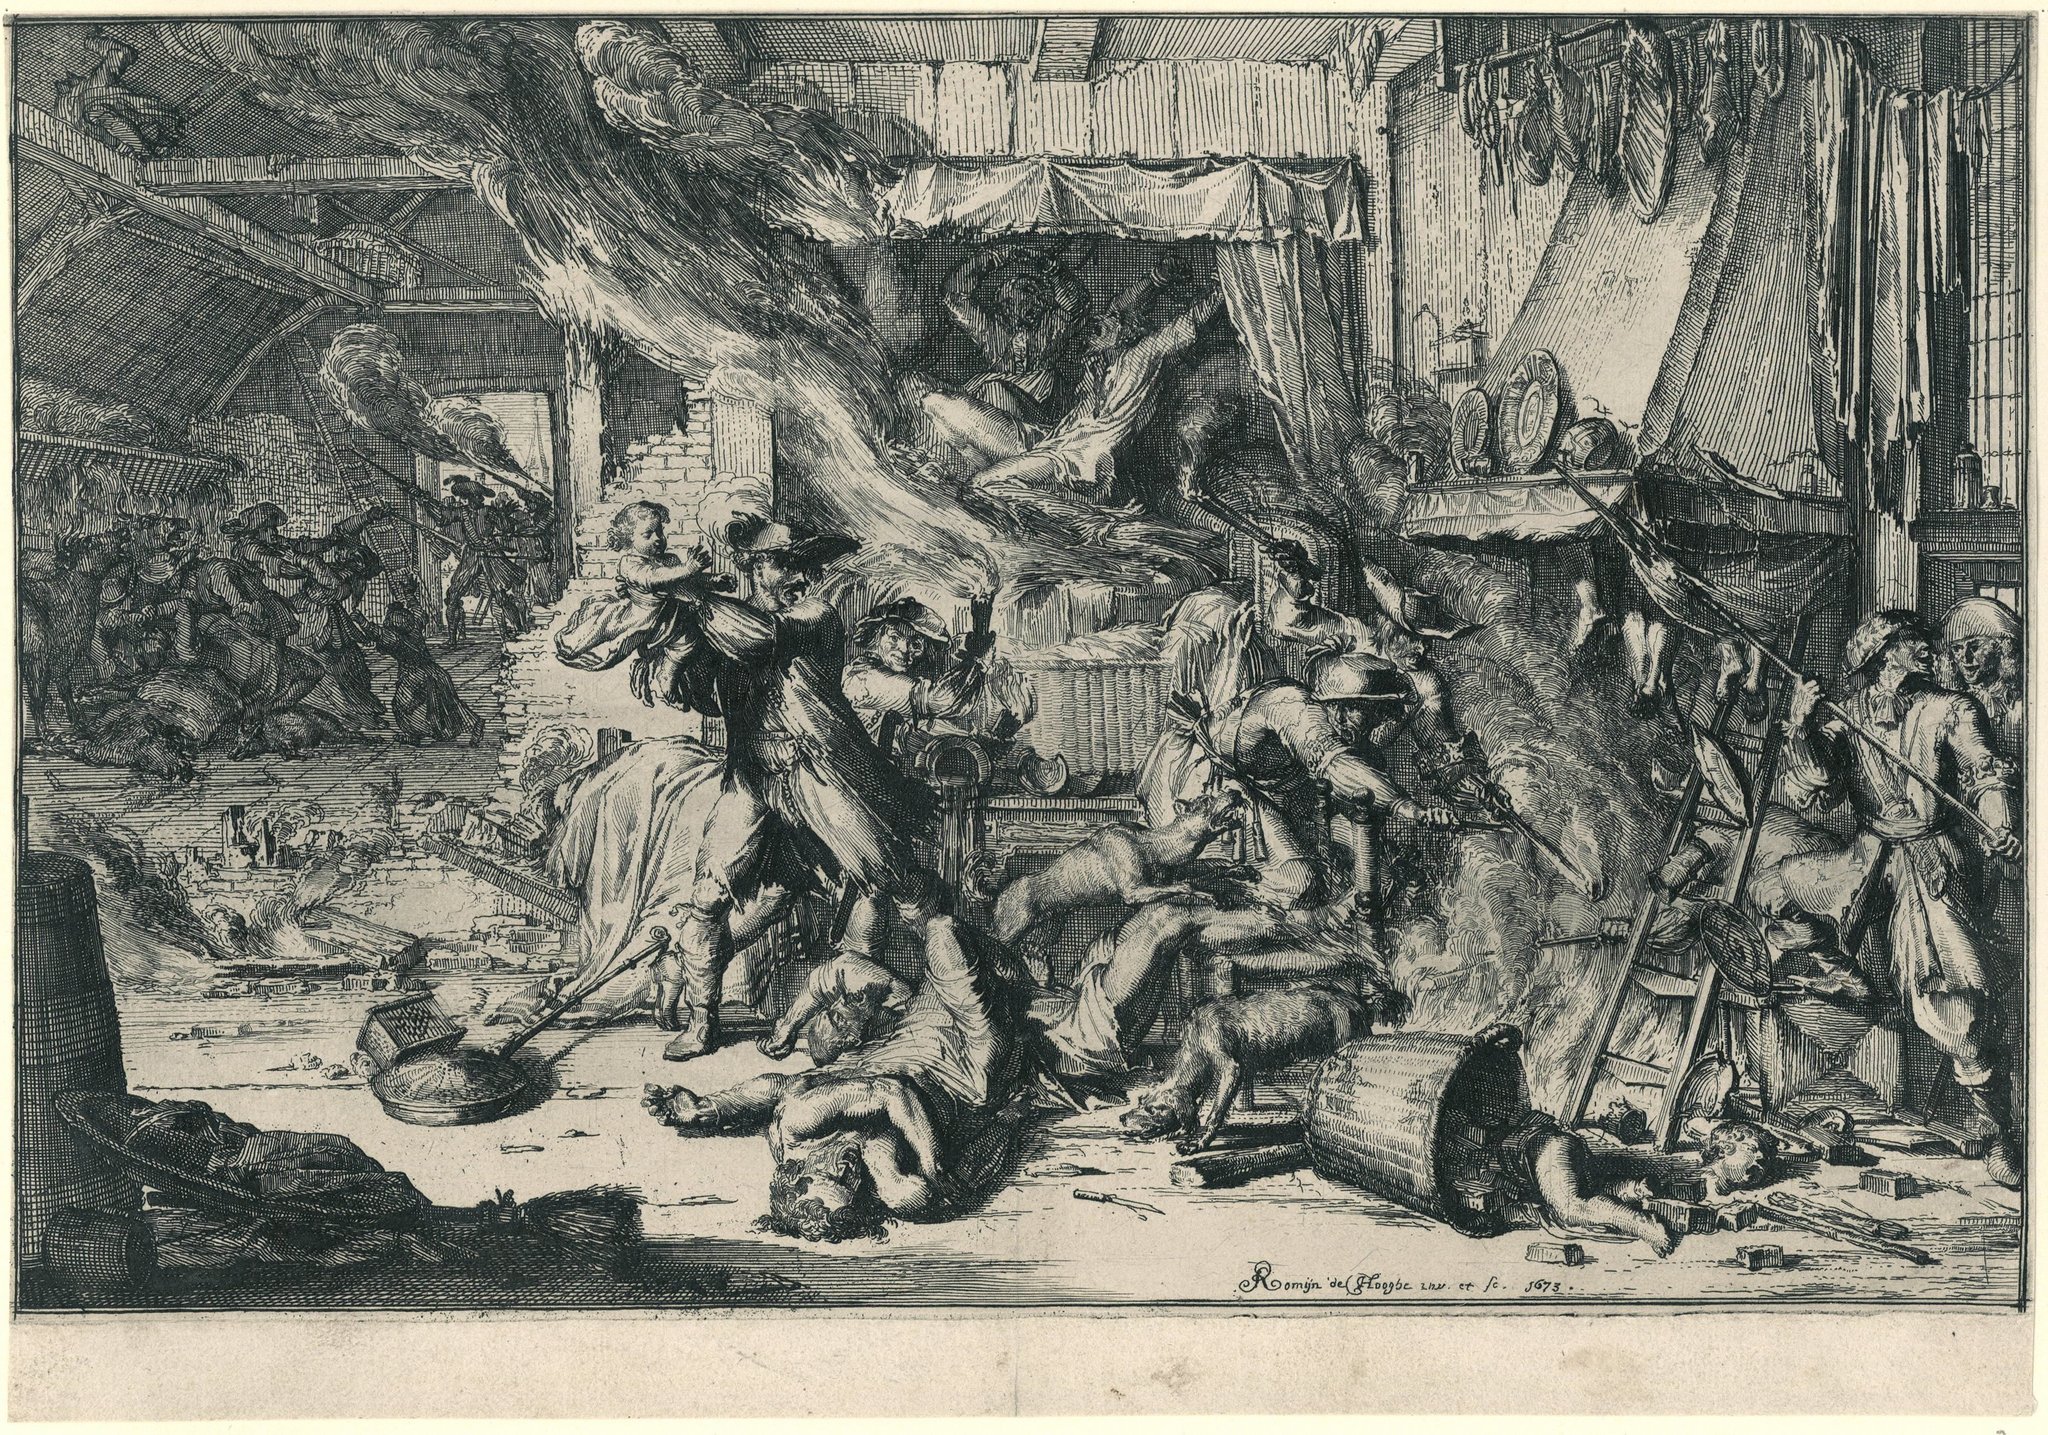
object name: print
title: Wreedheden in een boerenhoeve, 1672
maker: romeyn de hooghe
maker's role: draughtsman, goldsmith, painter, print maker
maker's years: 1645-1708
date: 1673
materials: paper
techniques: etching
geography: northern netherlands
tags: violent death, being killed; being mishandled and maltreated; seeking death, massacre ~ war, bodegraven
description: Illustratie voor: Wicquefort, Abraham van. Avis fidelle aux veritables hollandois. Touchant ce qui s’est passé dans les villages de Bodegrave & Swammerdam, & les cruautés inoüies, que les françois y ont exercées […]. S.l. [Den Haag]: s.n. [Daniel en Johannes Steucker], 1673.